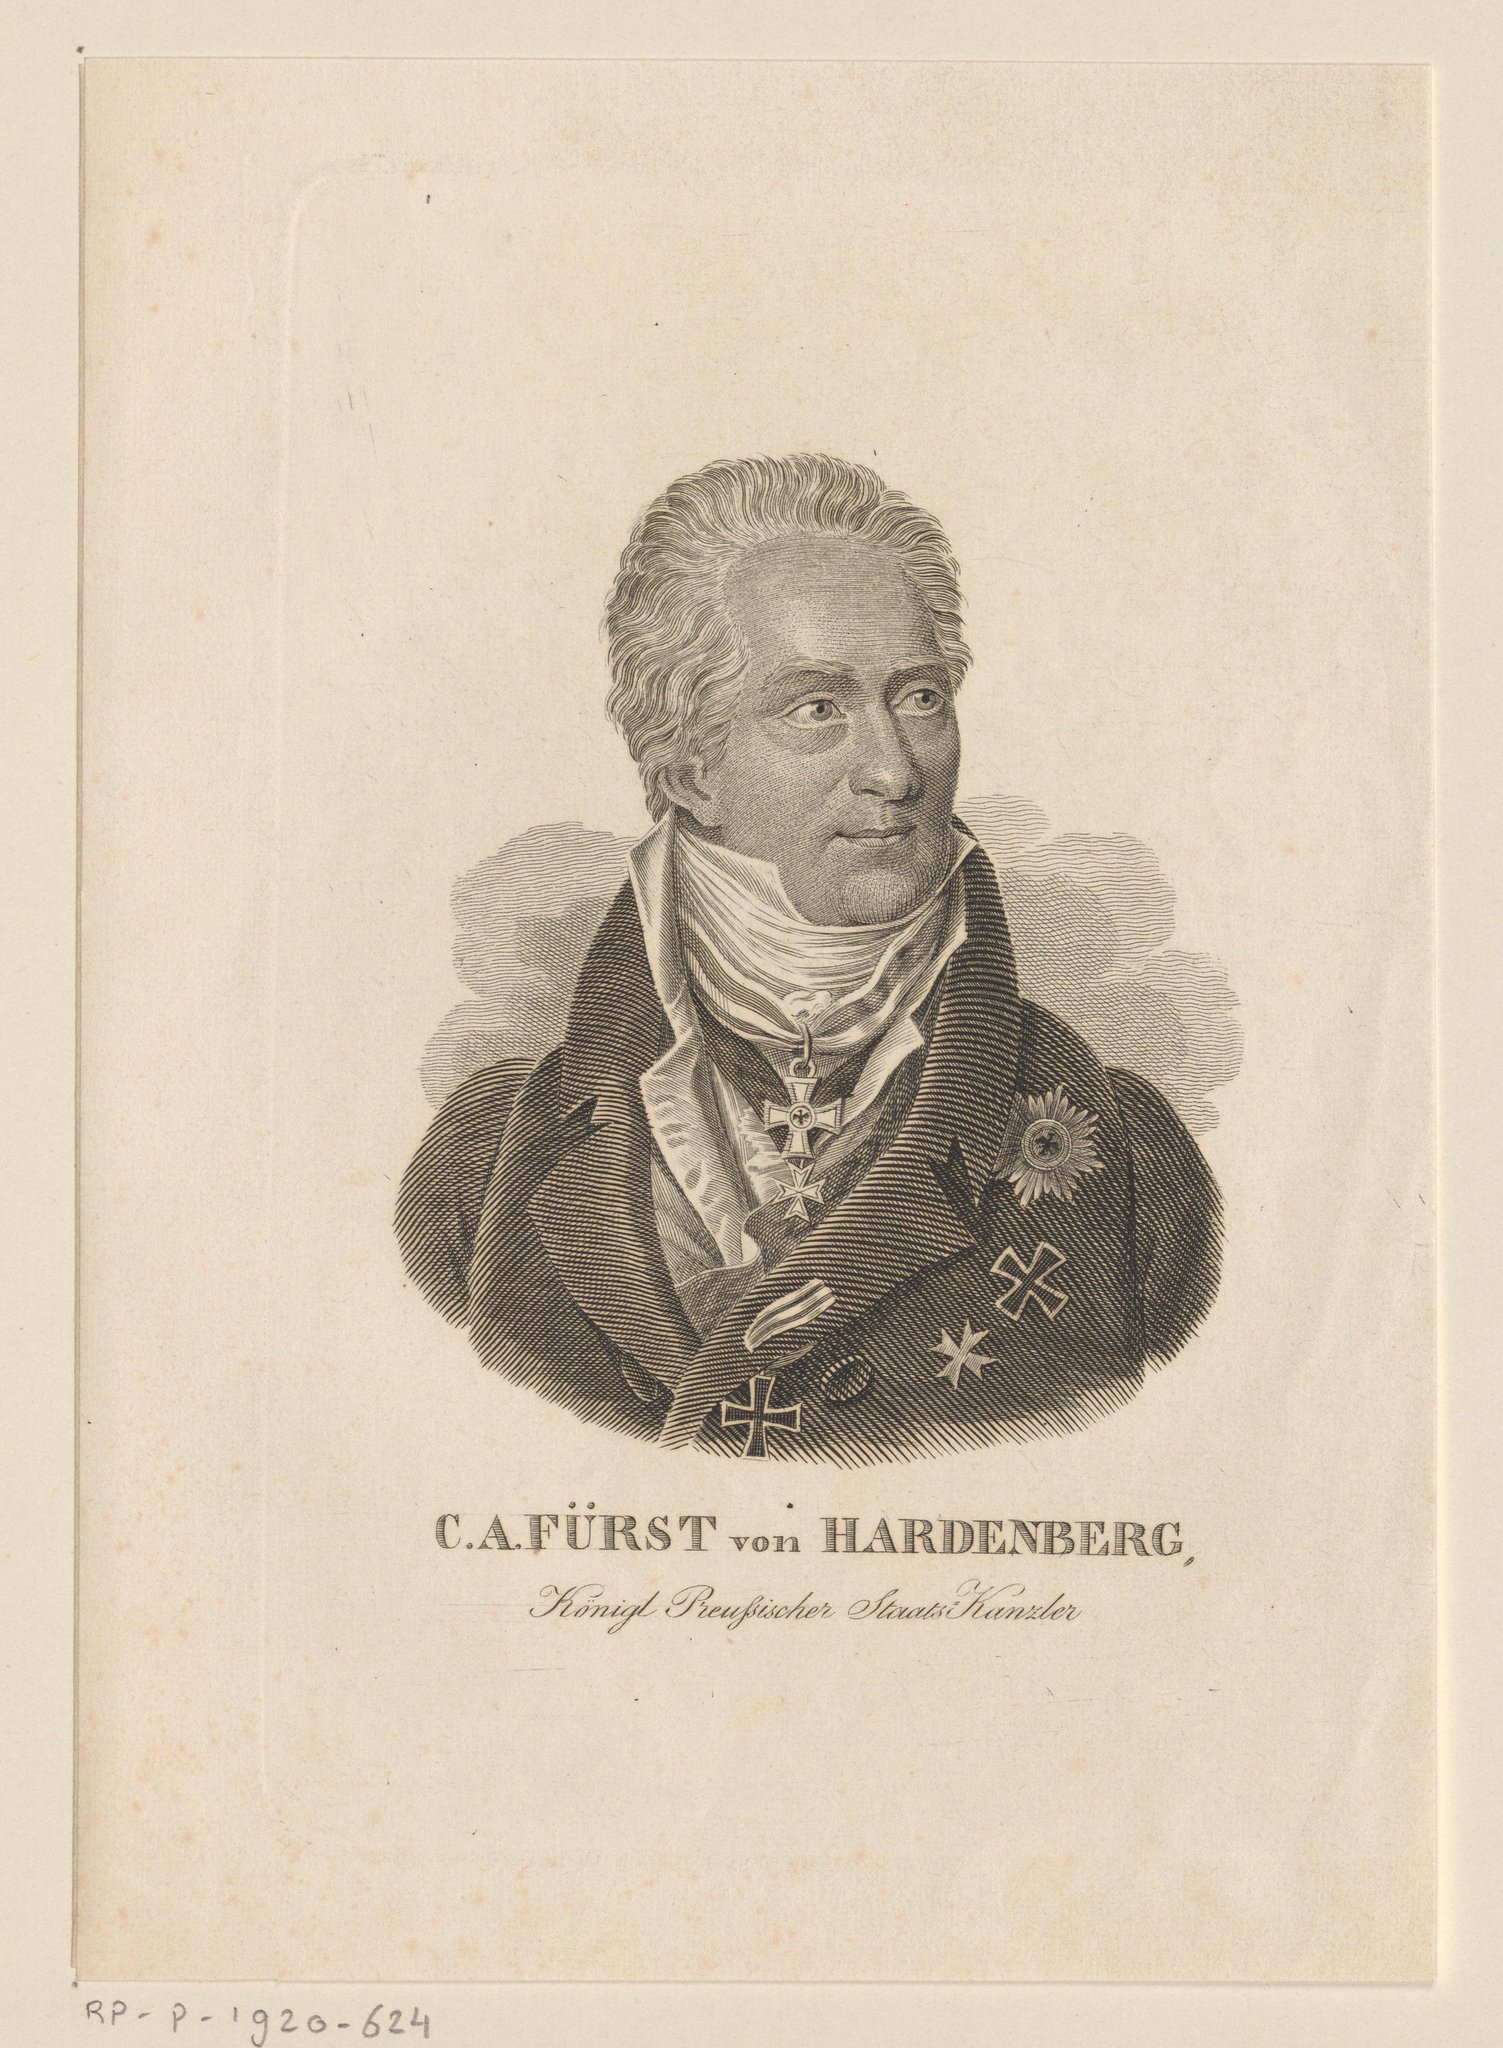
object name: print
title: Portret van Karl August von Hardenberg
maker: Anonymous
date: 1814-1849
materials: paper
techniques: engraving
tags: historical persons, politician, e.g. party leader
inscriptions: collector's mark: Lugt 2228